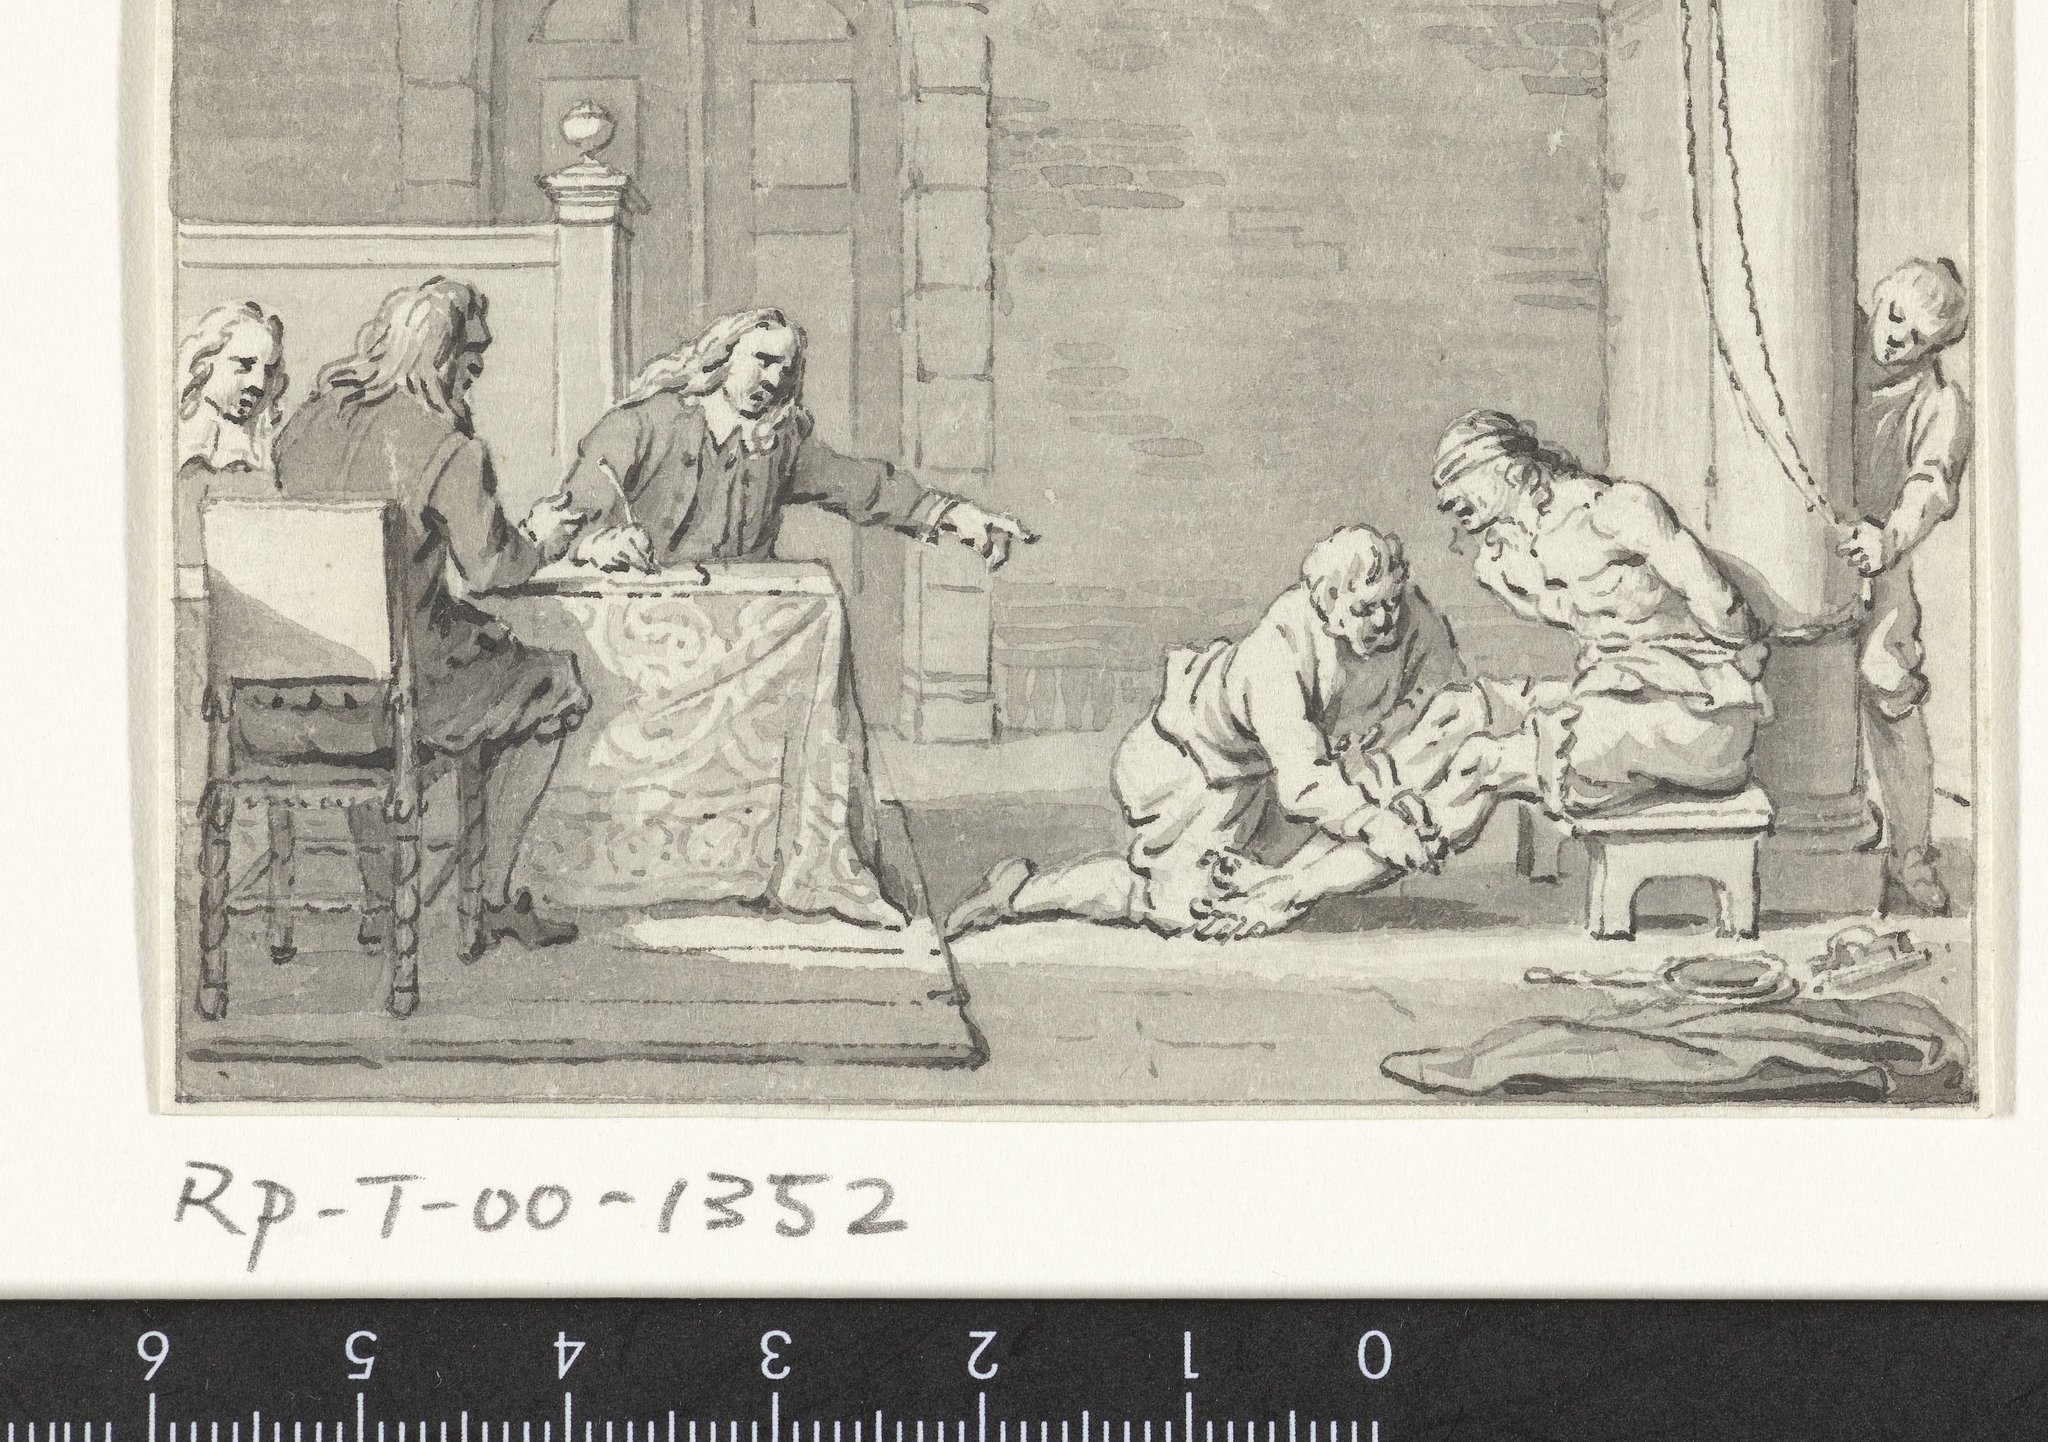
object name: drawing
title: Verhoor en marteling van Cornelis de Witt, 1672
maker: jacobus buys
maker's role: draughtsman, print maker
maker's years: 1724-1801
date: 1787-1788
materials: ink, paper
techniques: brush, pen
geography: northern netherlands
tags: dordrecht, the hague, cornelis de witt, torture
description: Ontwerptekening voor illustratie in: J.F. Martinet, Het vereenigd Nederland, J. Allart, Amsterdam 1788.